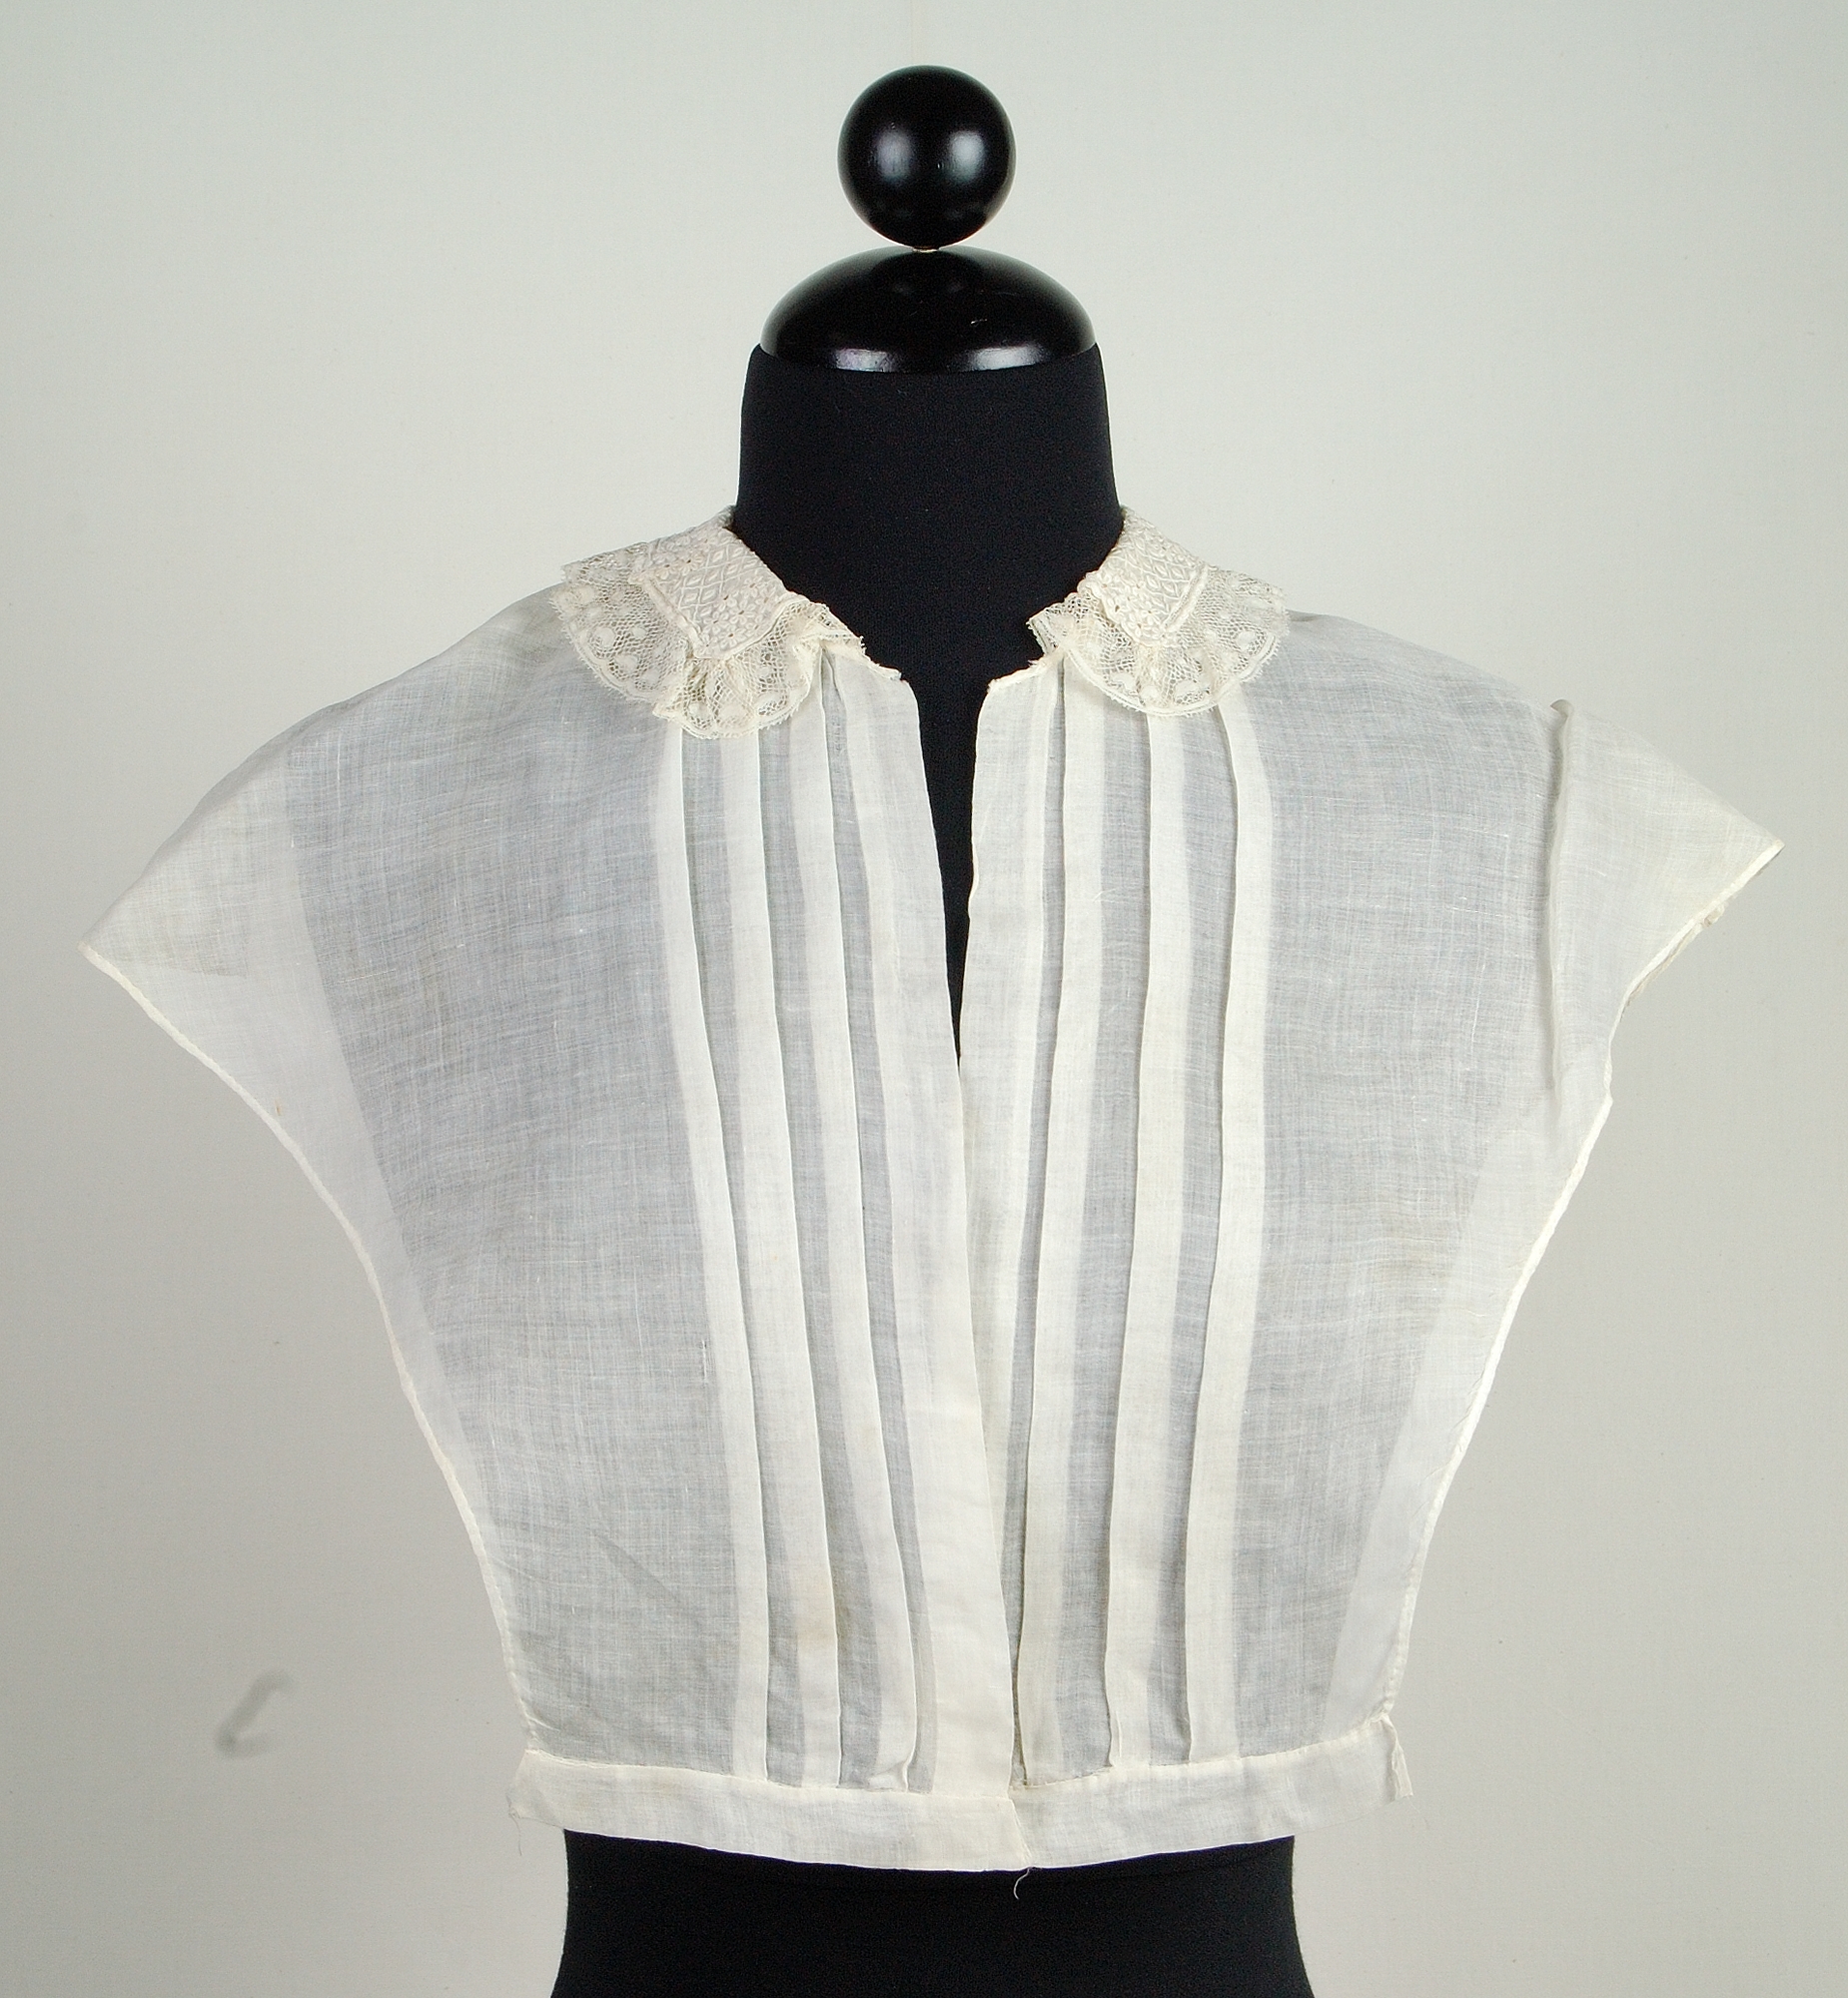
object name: chemise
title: Chemisette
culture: american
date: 1860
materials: linen